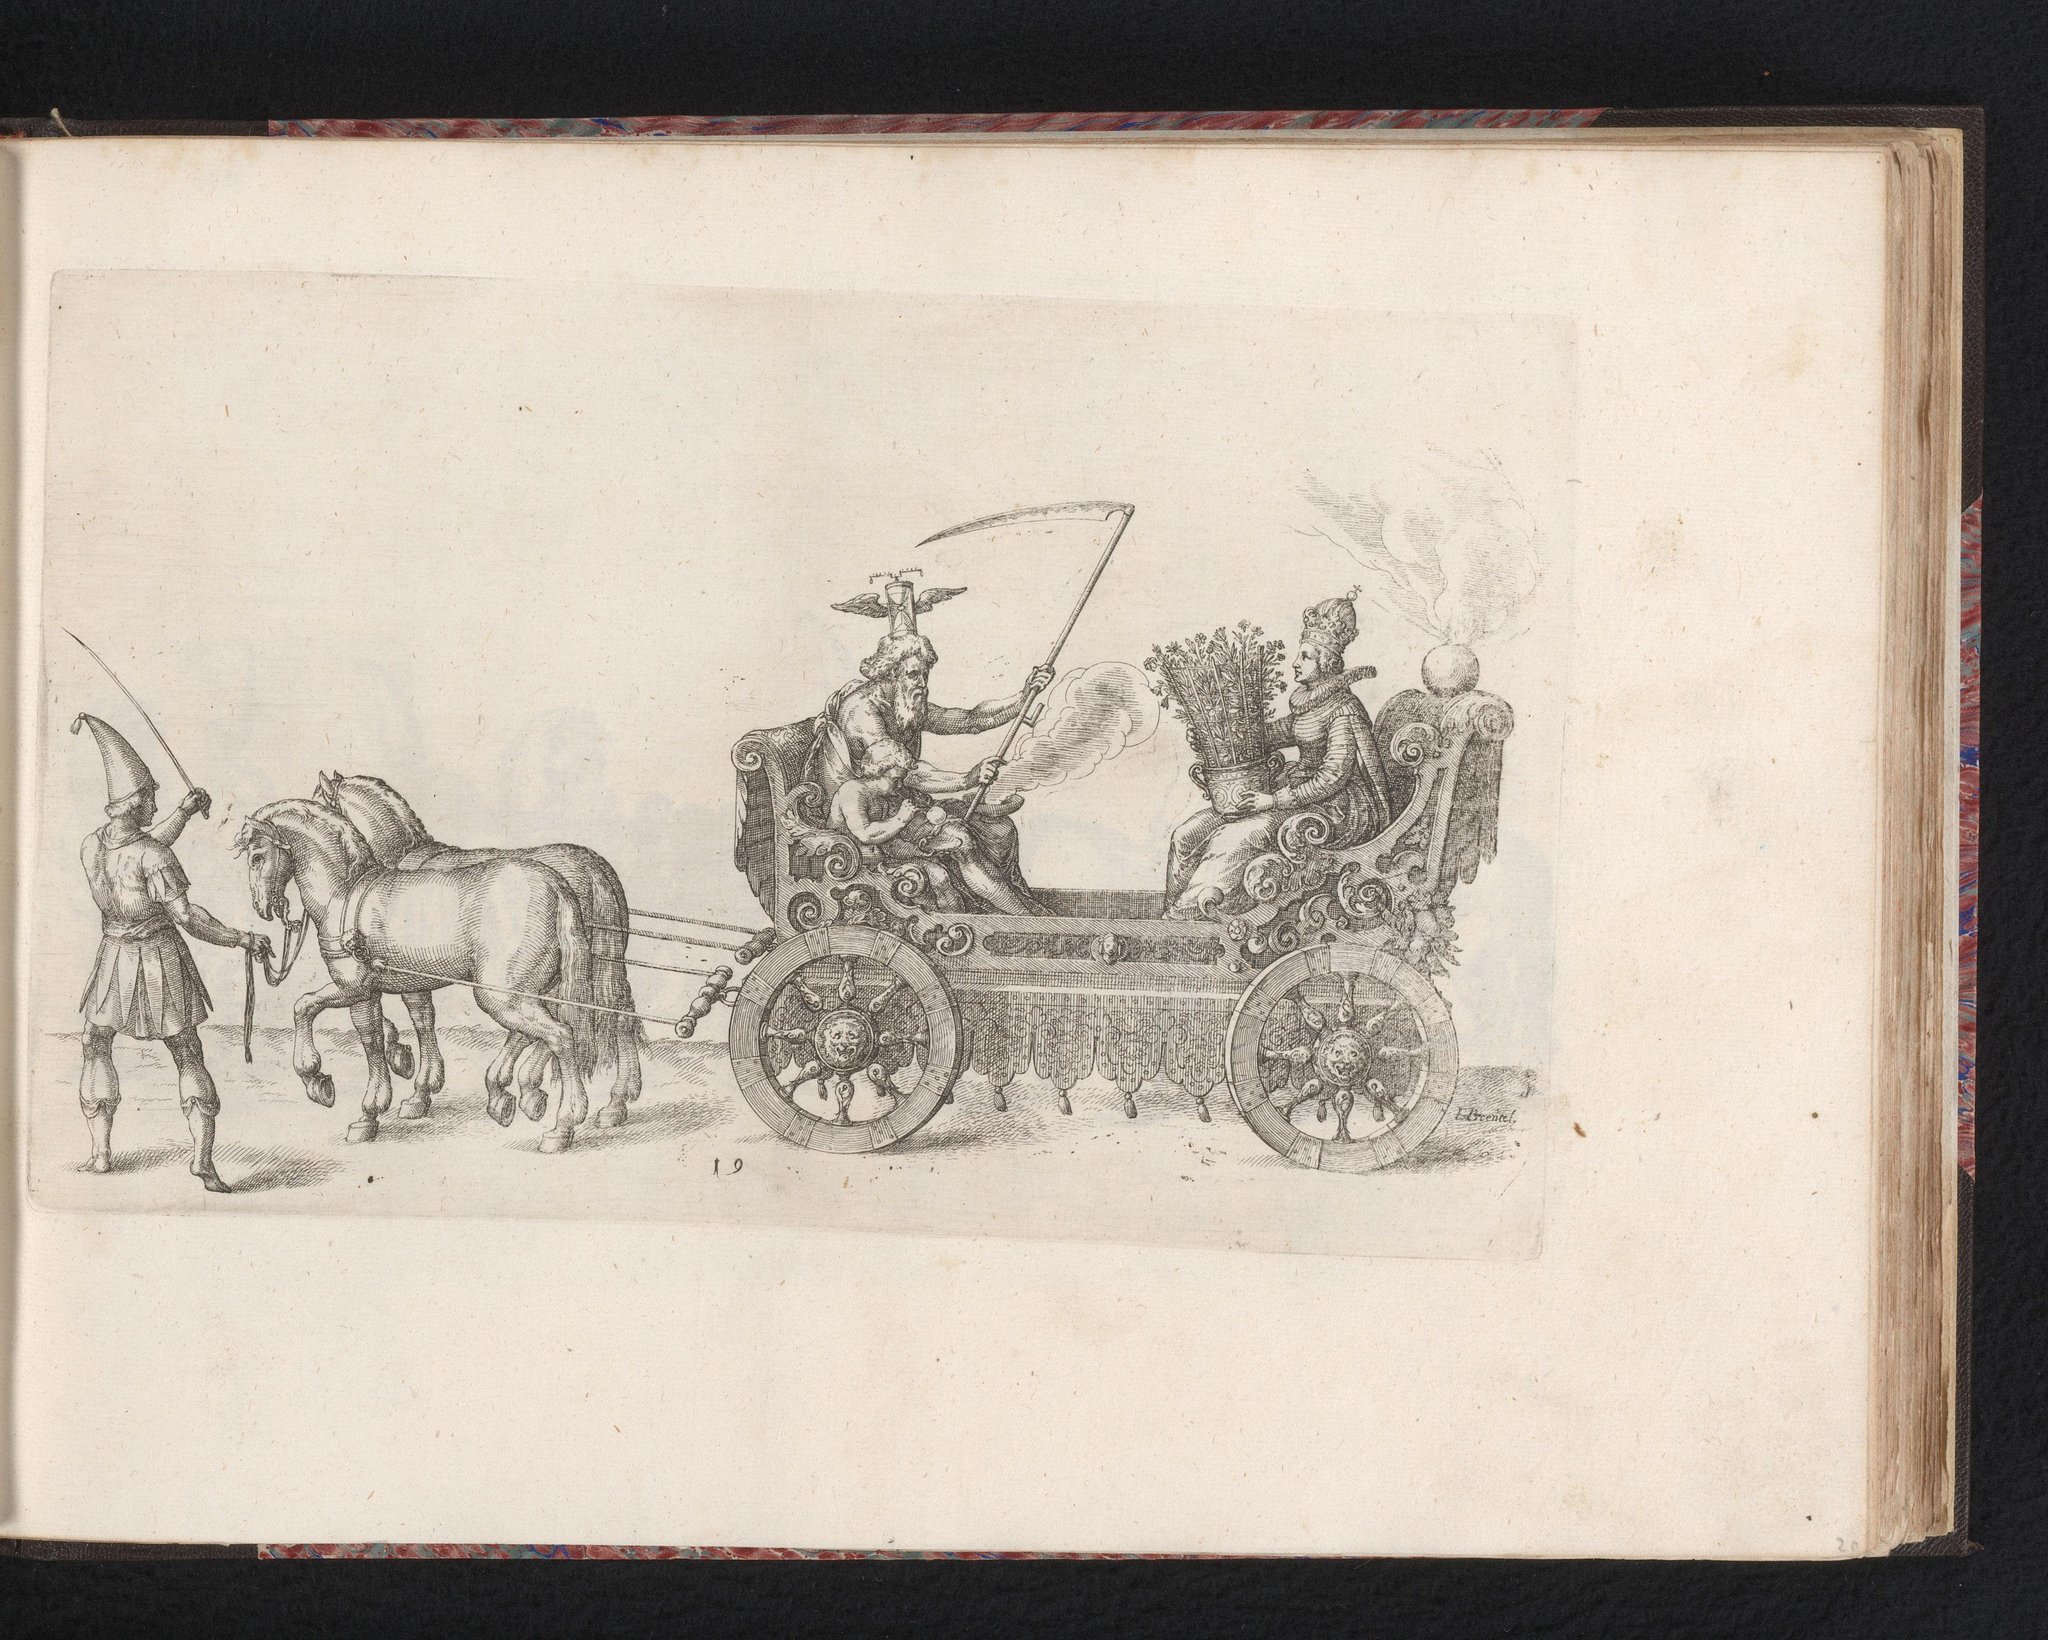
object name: album leaf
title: Aigentliche wahrhaffte Delineation unnd Abbildung aller fürstlichen Auffzüg und Rütterspilen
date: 1618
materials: paper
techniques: etching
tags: private soldier (+ cavalry, horsemen), temperance, 'temperantia'; 'temperanza' (ripa) ~ one of the four cardinal virtues, fortitude, 'fortitudo' ~ one of the four cardinal virtues - mm - triumph, stability, firmness; 'fermezza', 'stabilimento', 'stabilità' (ripa), performance in the open air (pleasure fair)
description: Genummerd: 18. Deze prent maakt deel uit van een album.